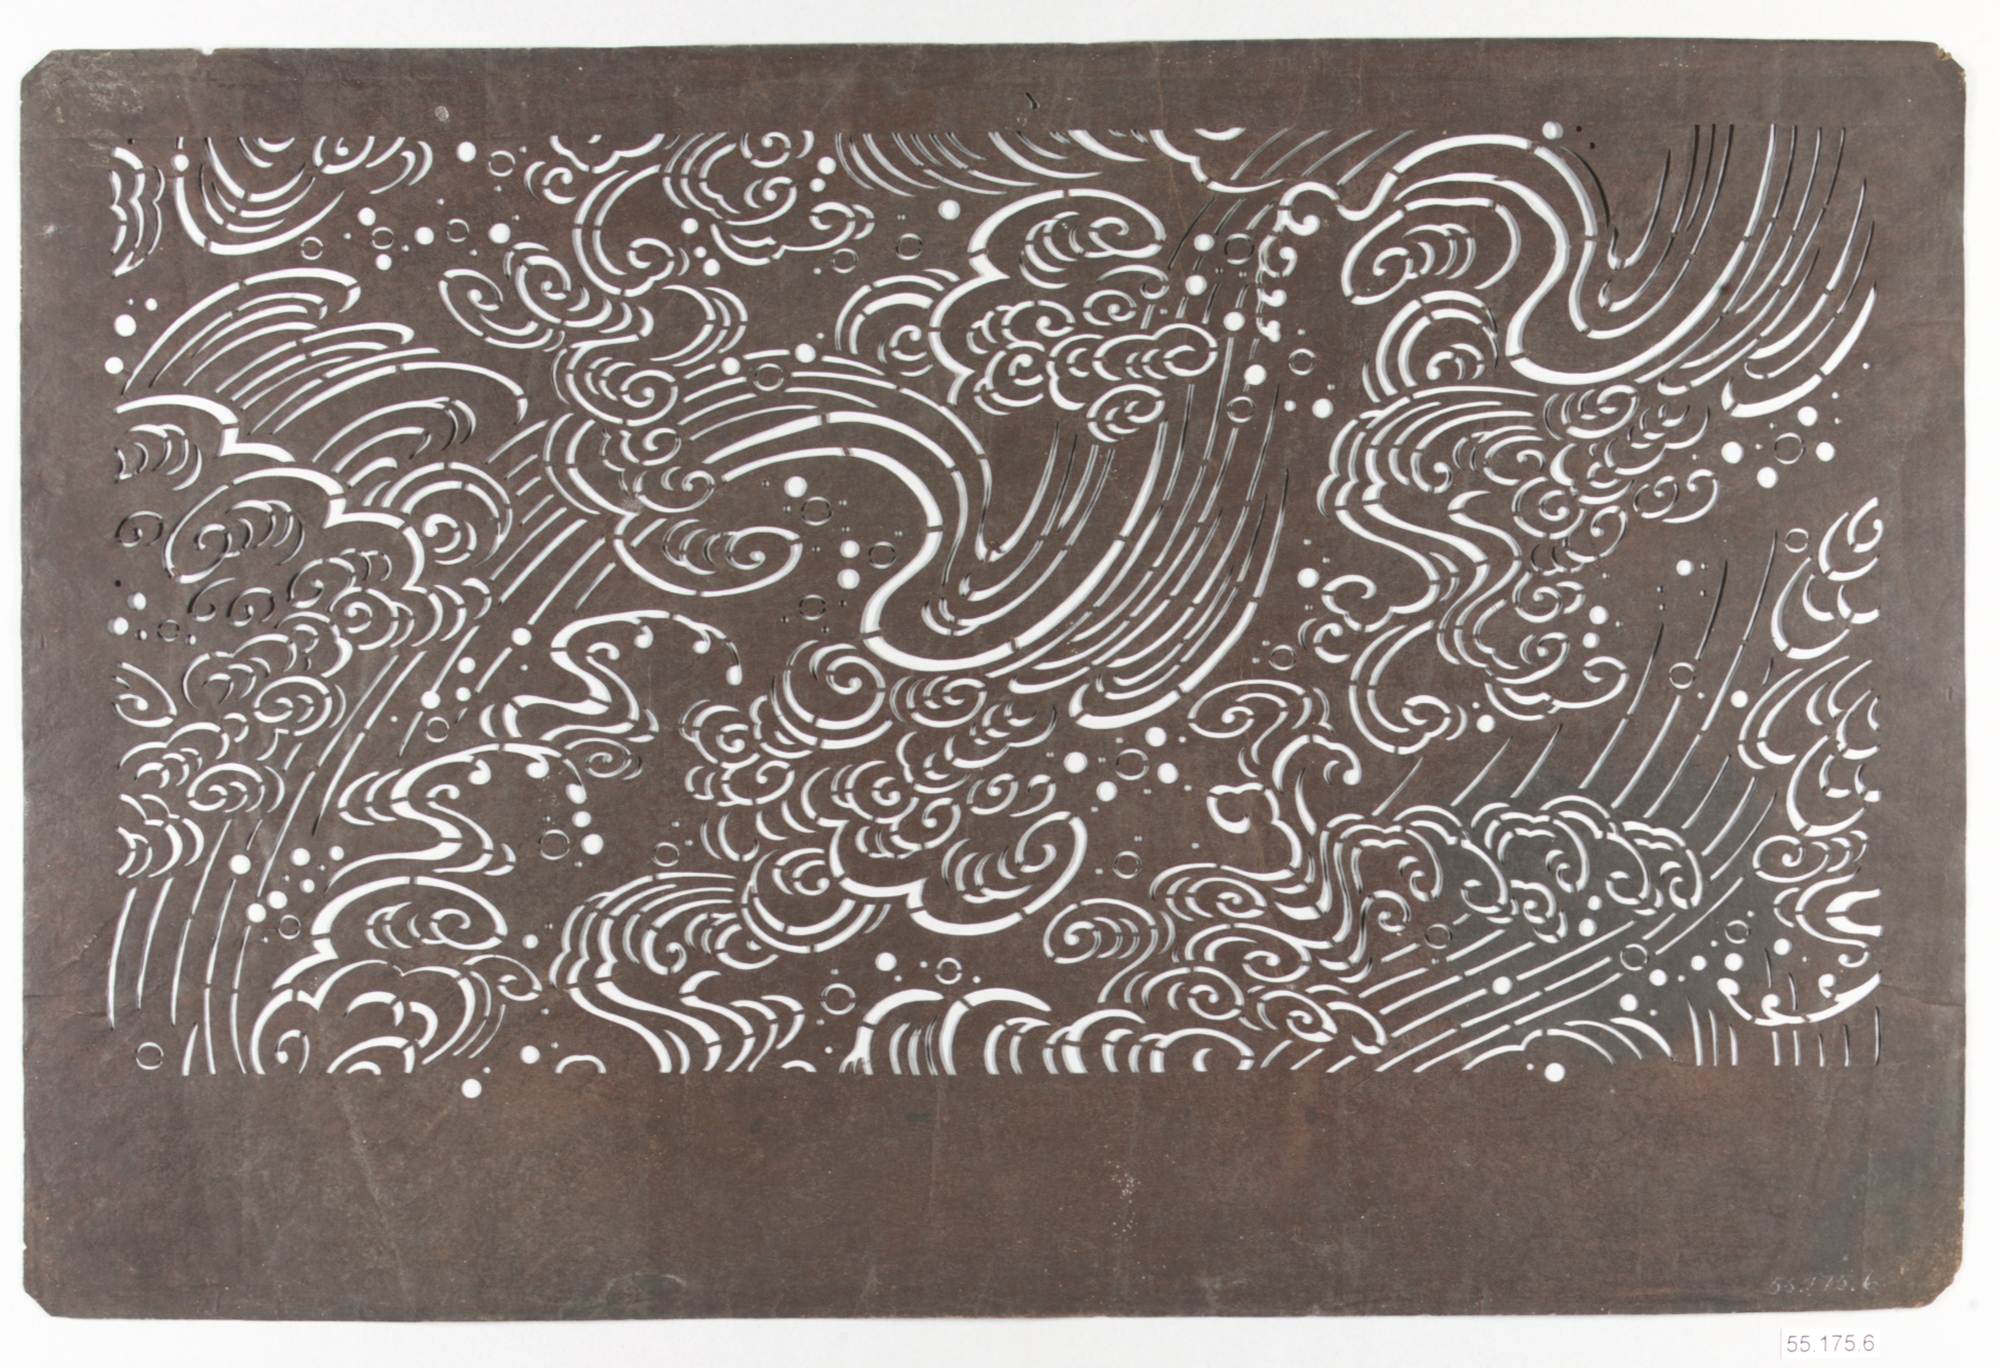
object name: stencil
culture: japanese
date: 1801-1900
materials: paper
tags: waves